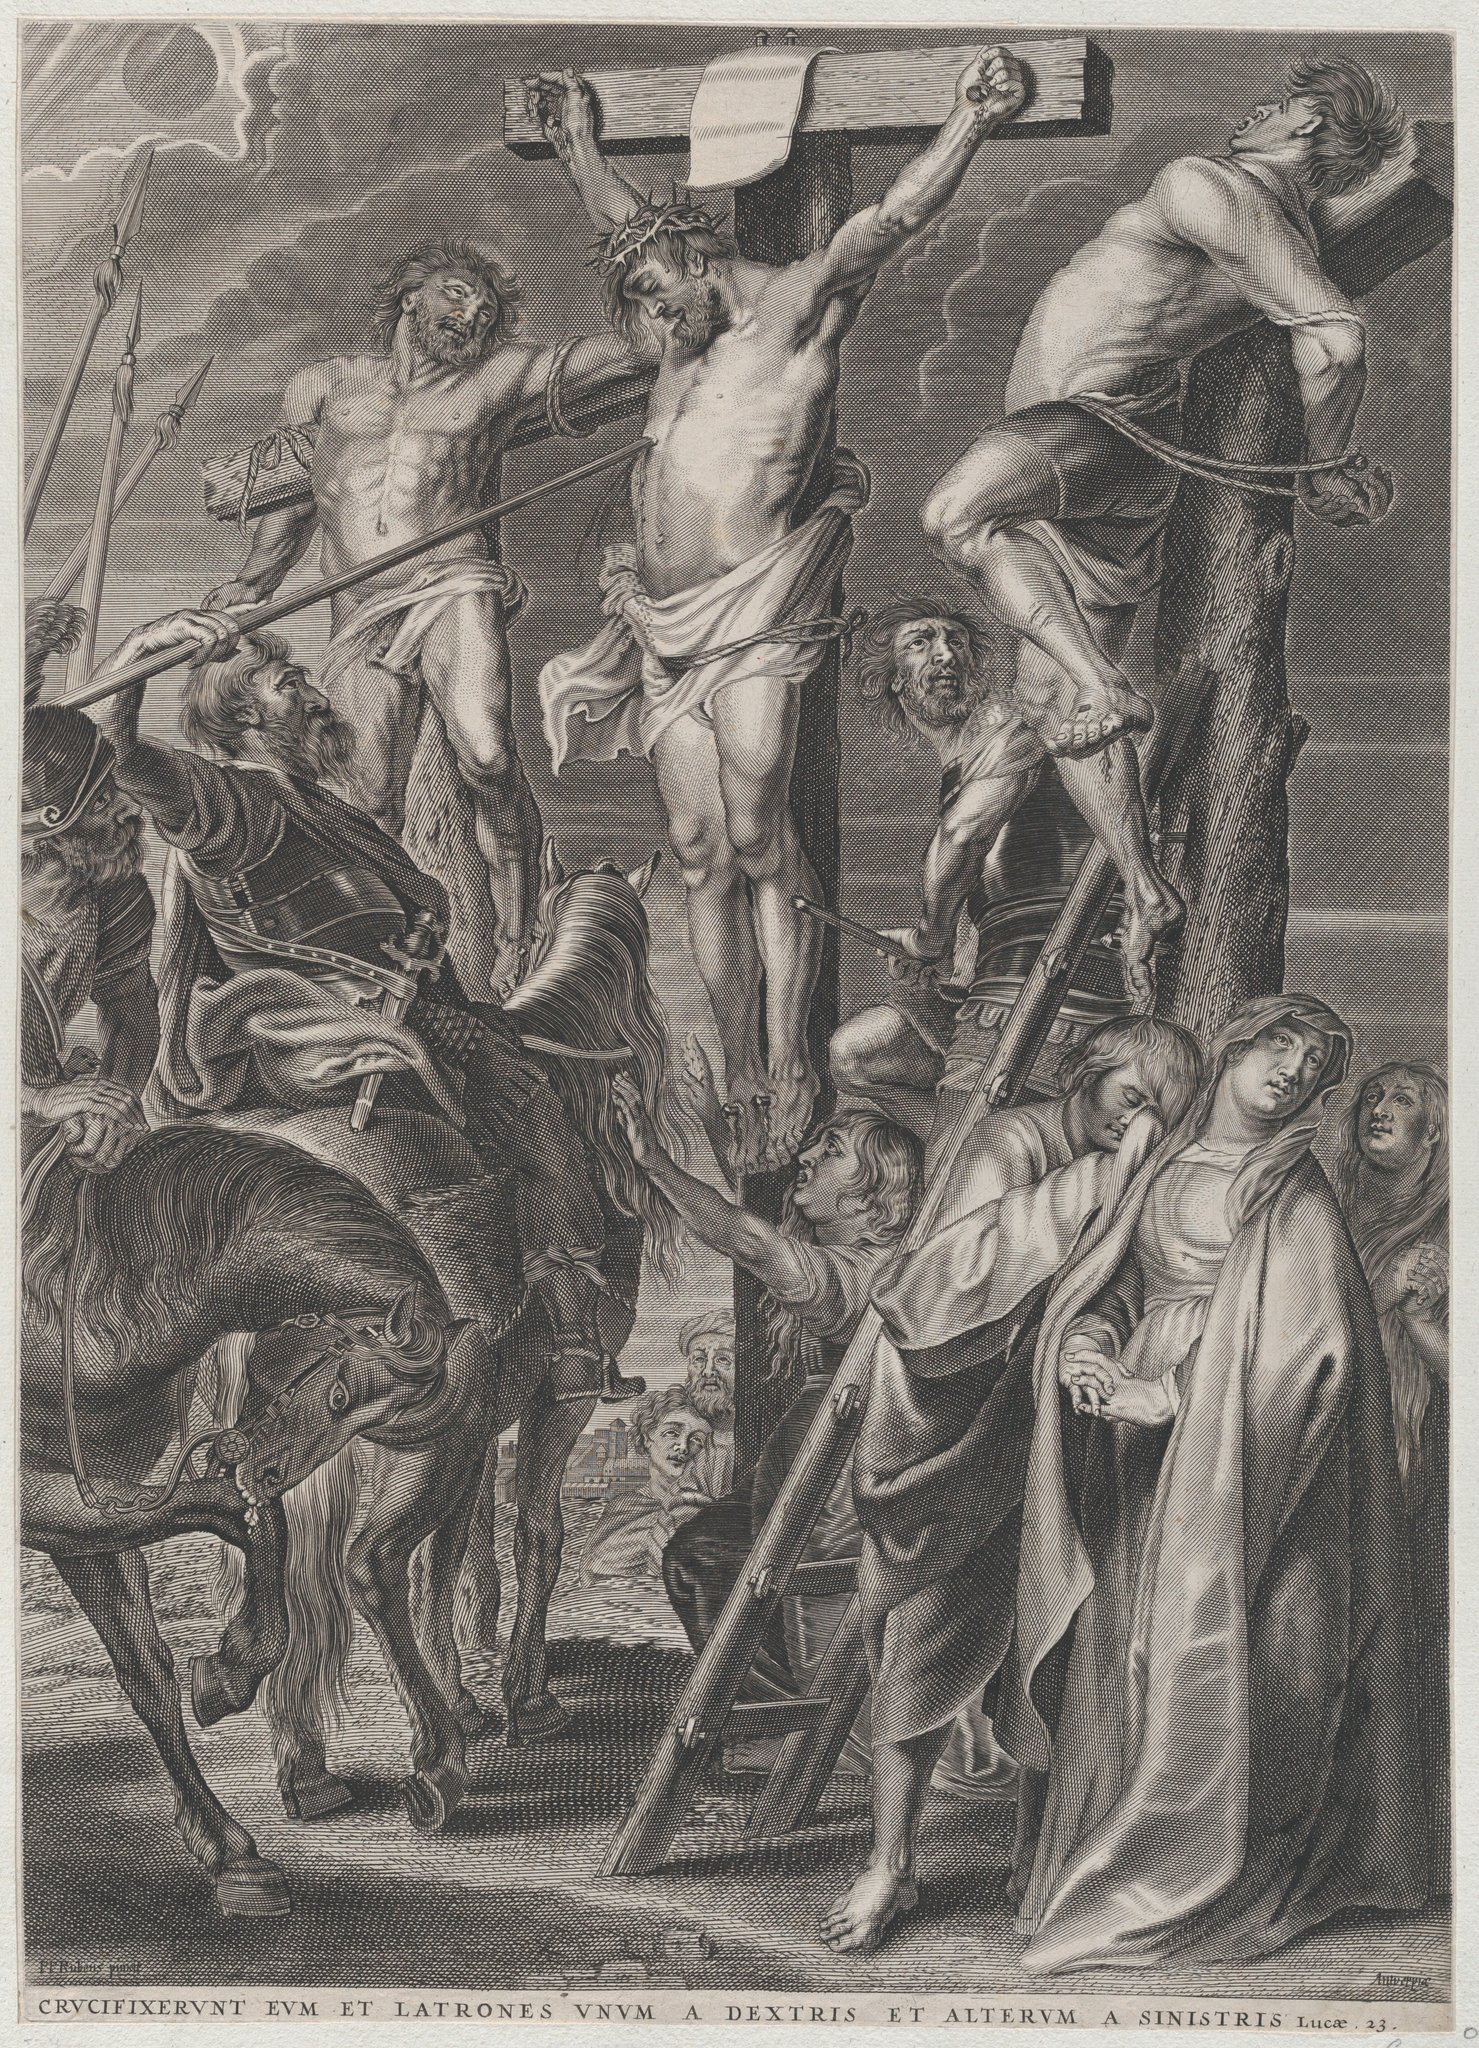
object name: print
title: Christ on the cross between the two thieves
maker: Anonymous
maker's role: artist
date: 1631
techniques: engraving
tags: horses,christ,crucifixion